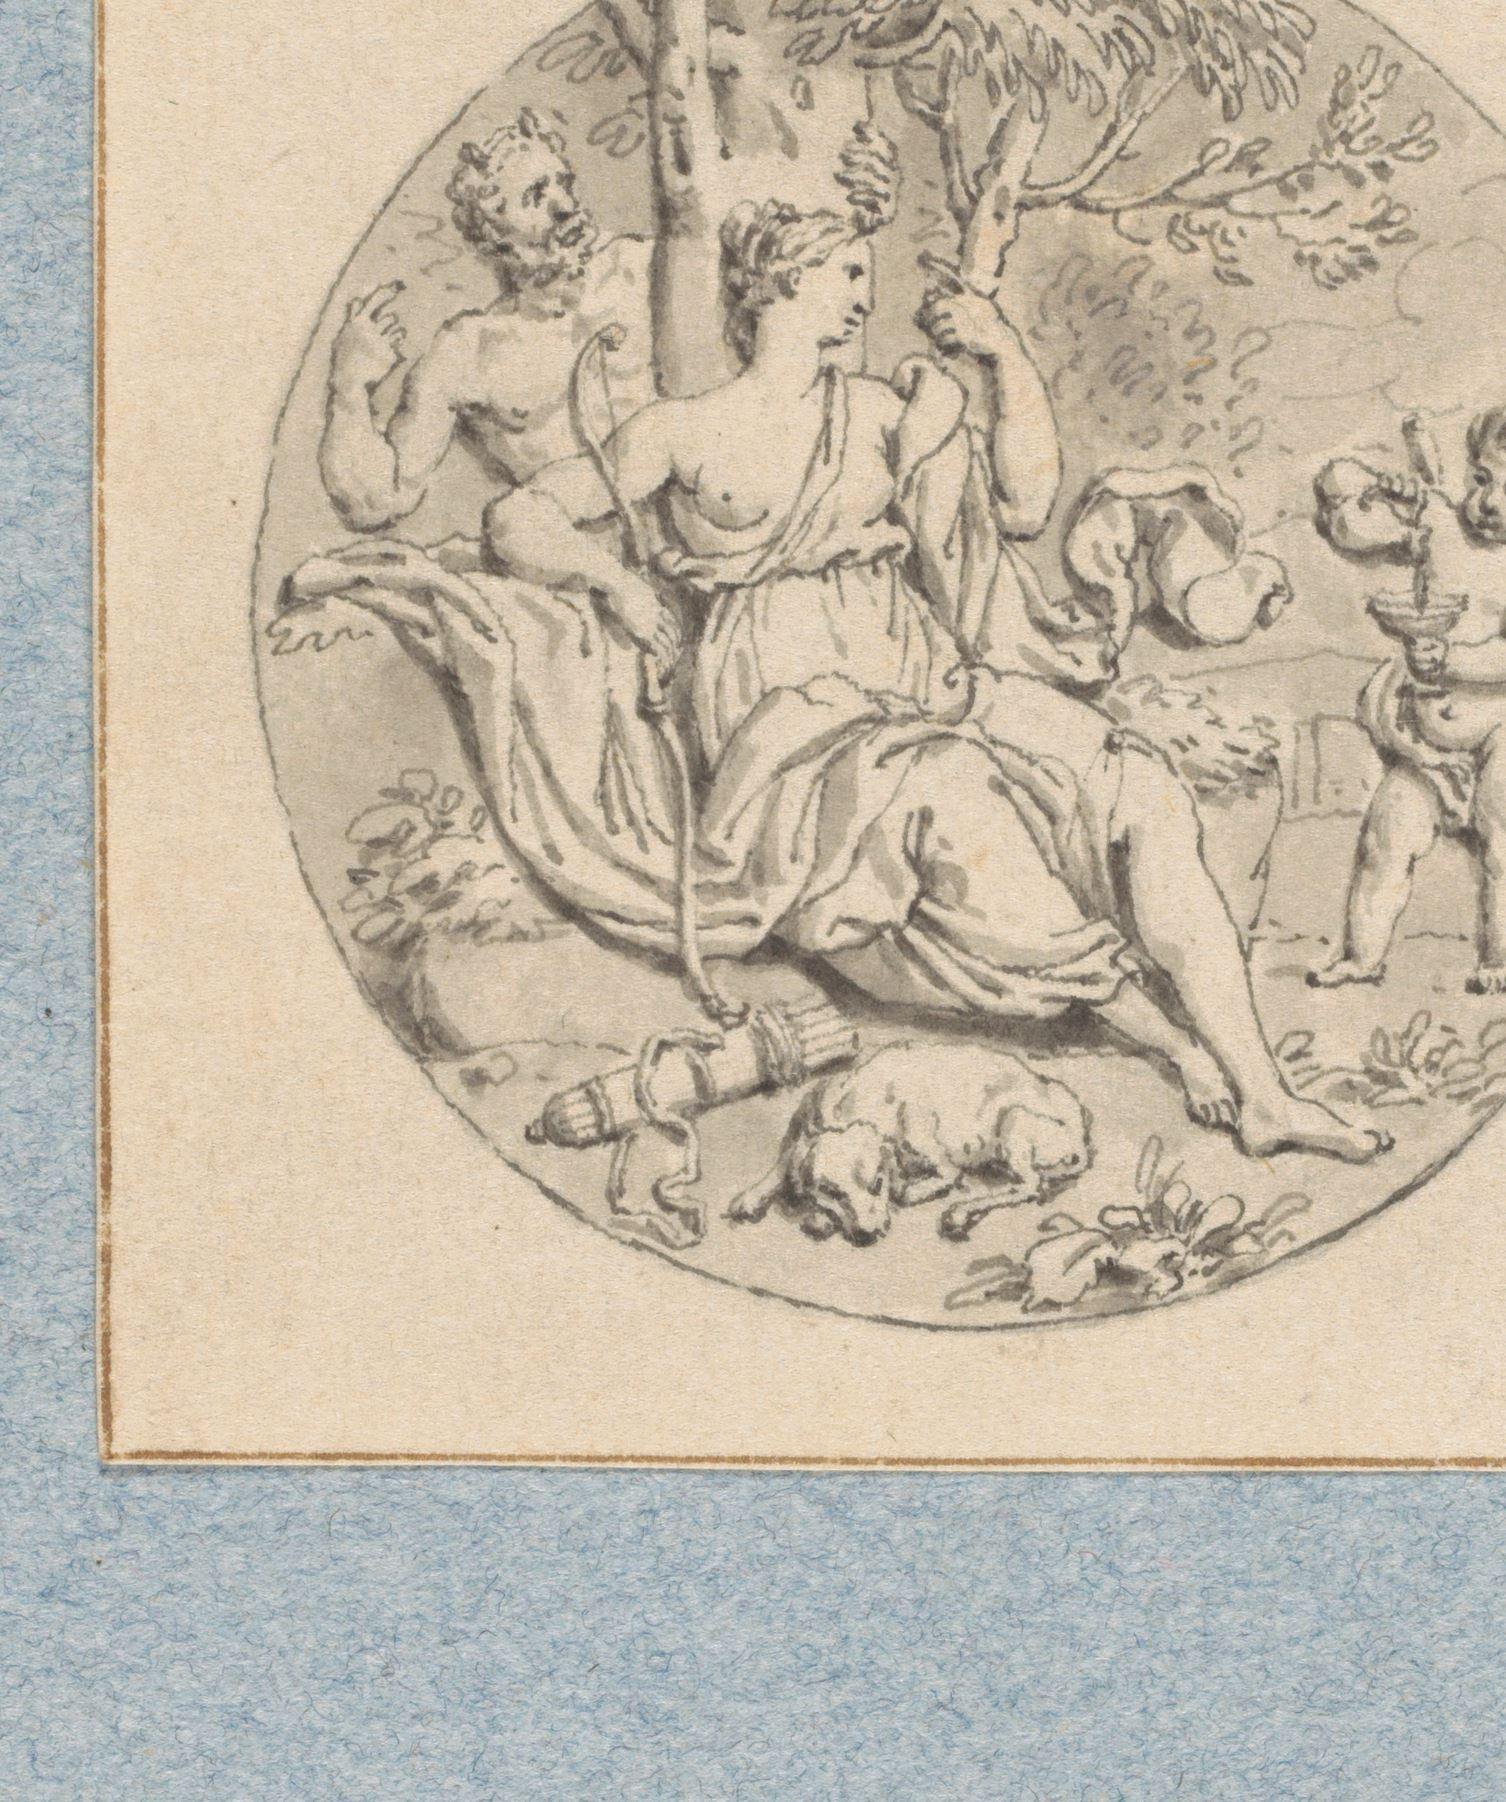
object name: drawing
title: Diana met sater en Cupido (in doos met 43 tekeningen)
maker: louis fabritius dubourg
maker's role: draughtsman, print maker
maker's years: 1693-1775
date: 1731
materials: ink, paper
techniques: brush, pen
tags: (story of) diana (artemis)